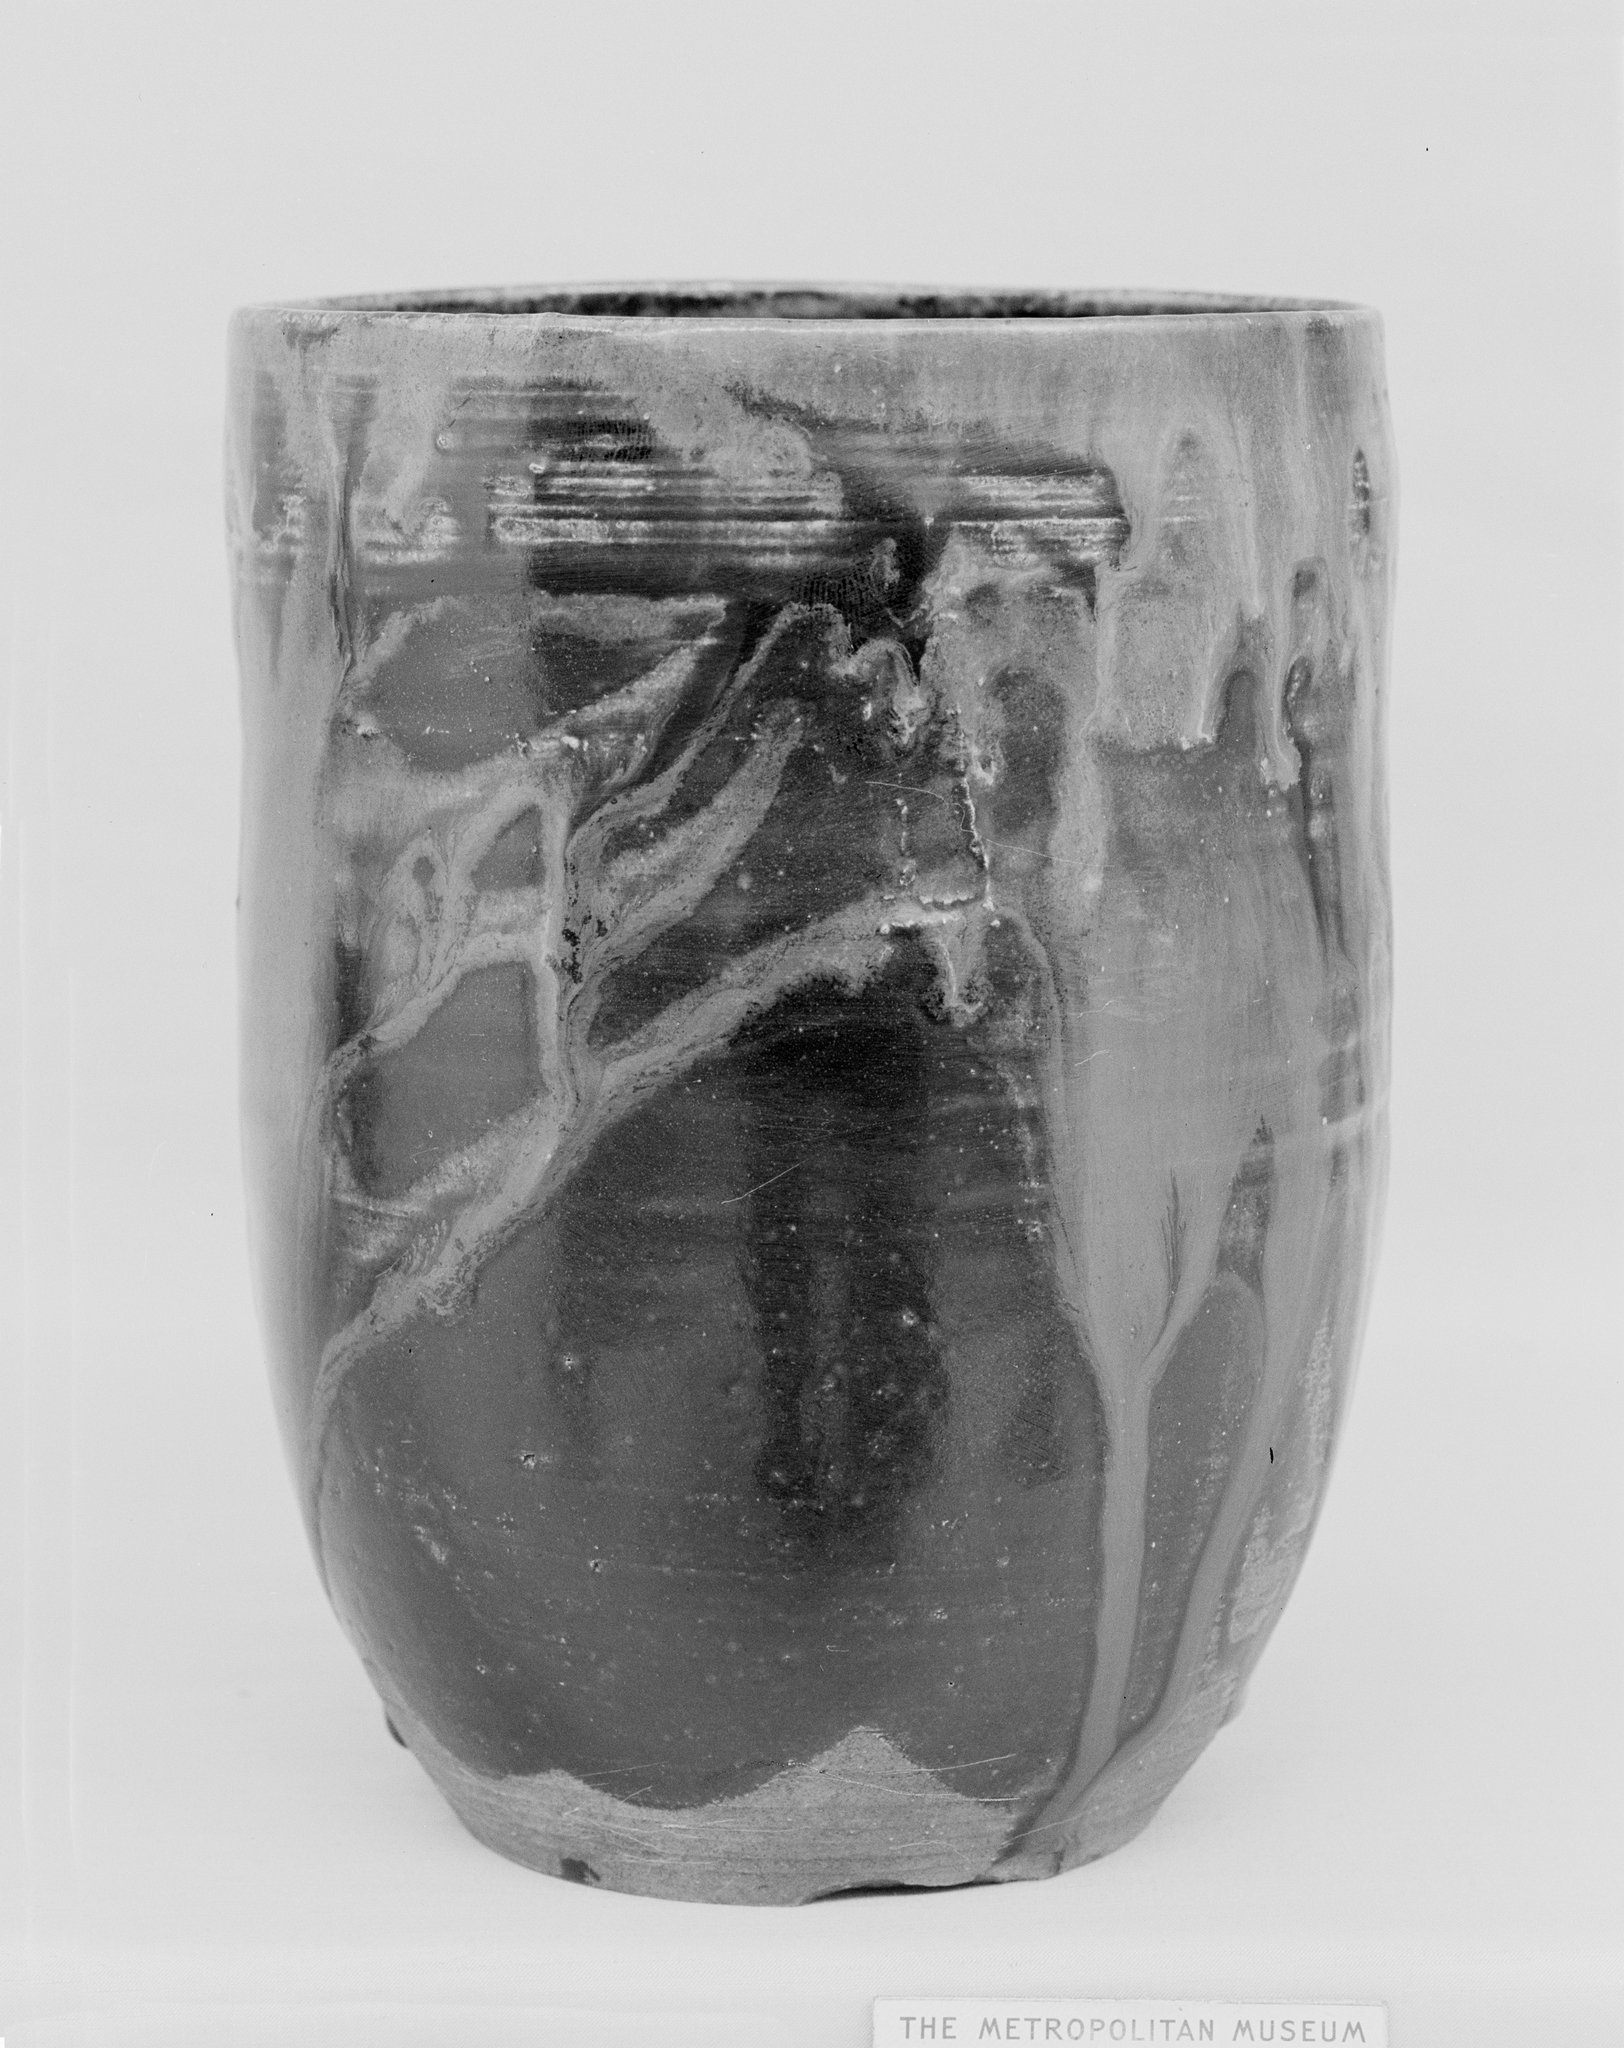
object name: water pot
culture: japanese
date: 1801-1900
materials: clay, glaze